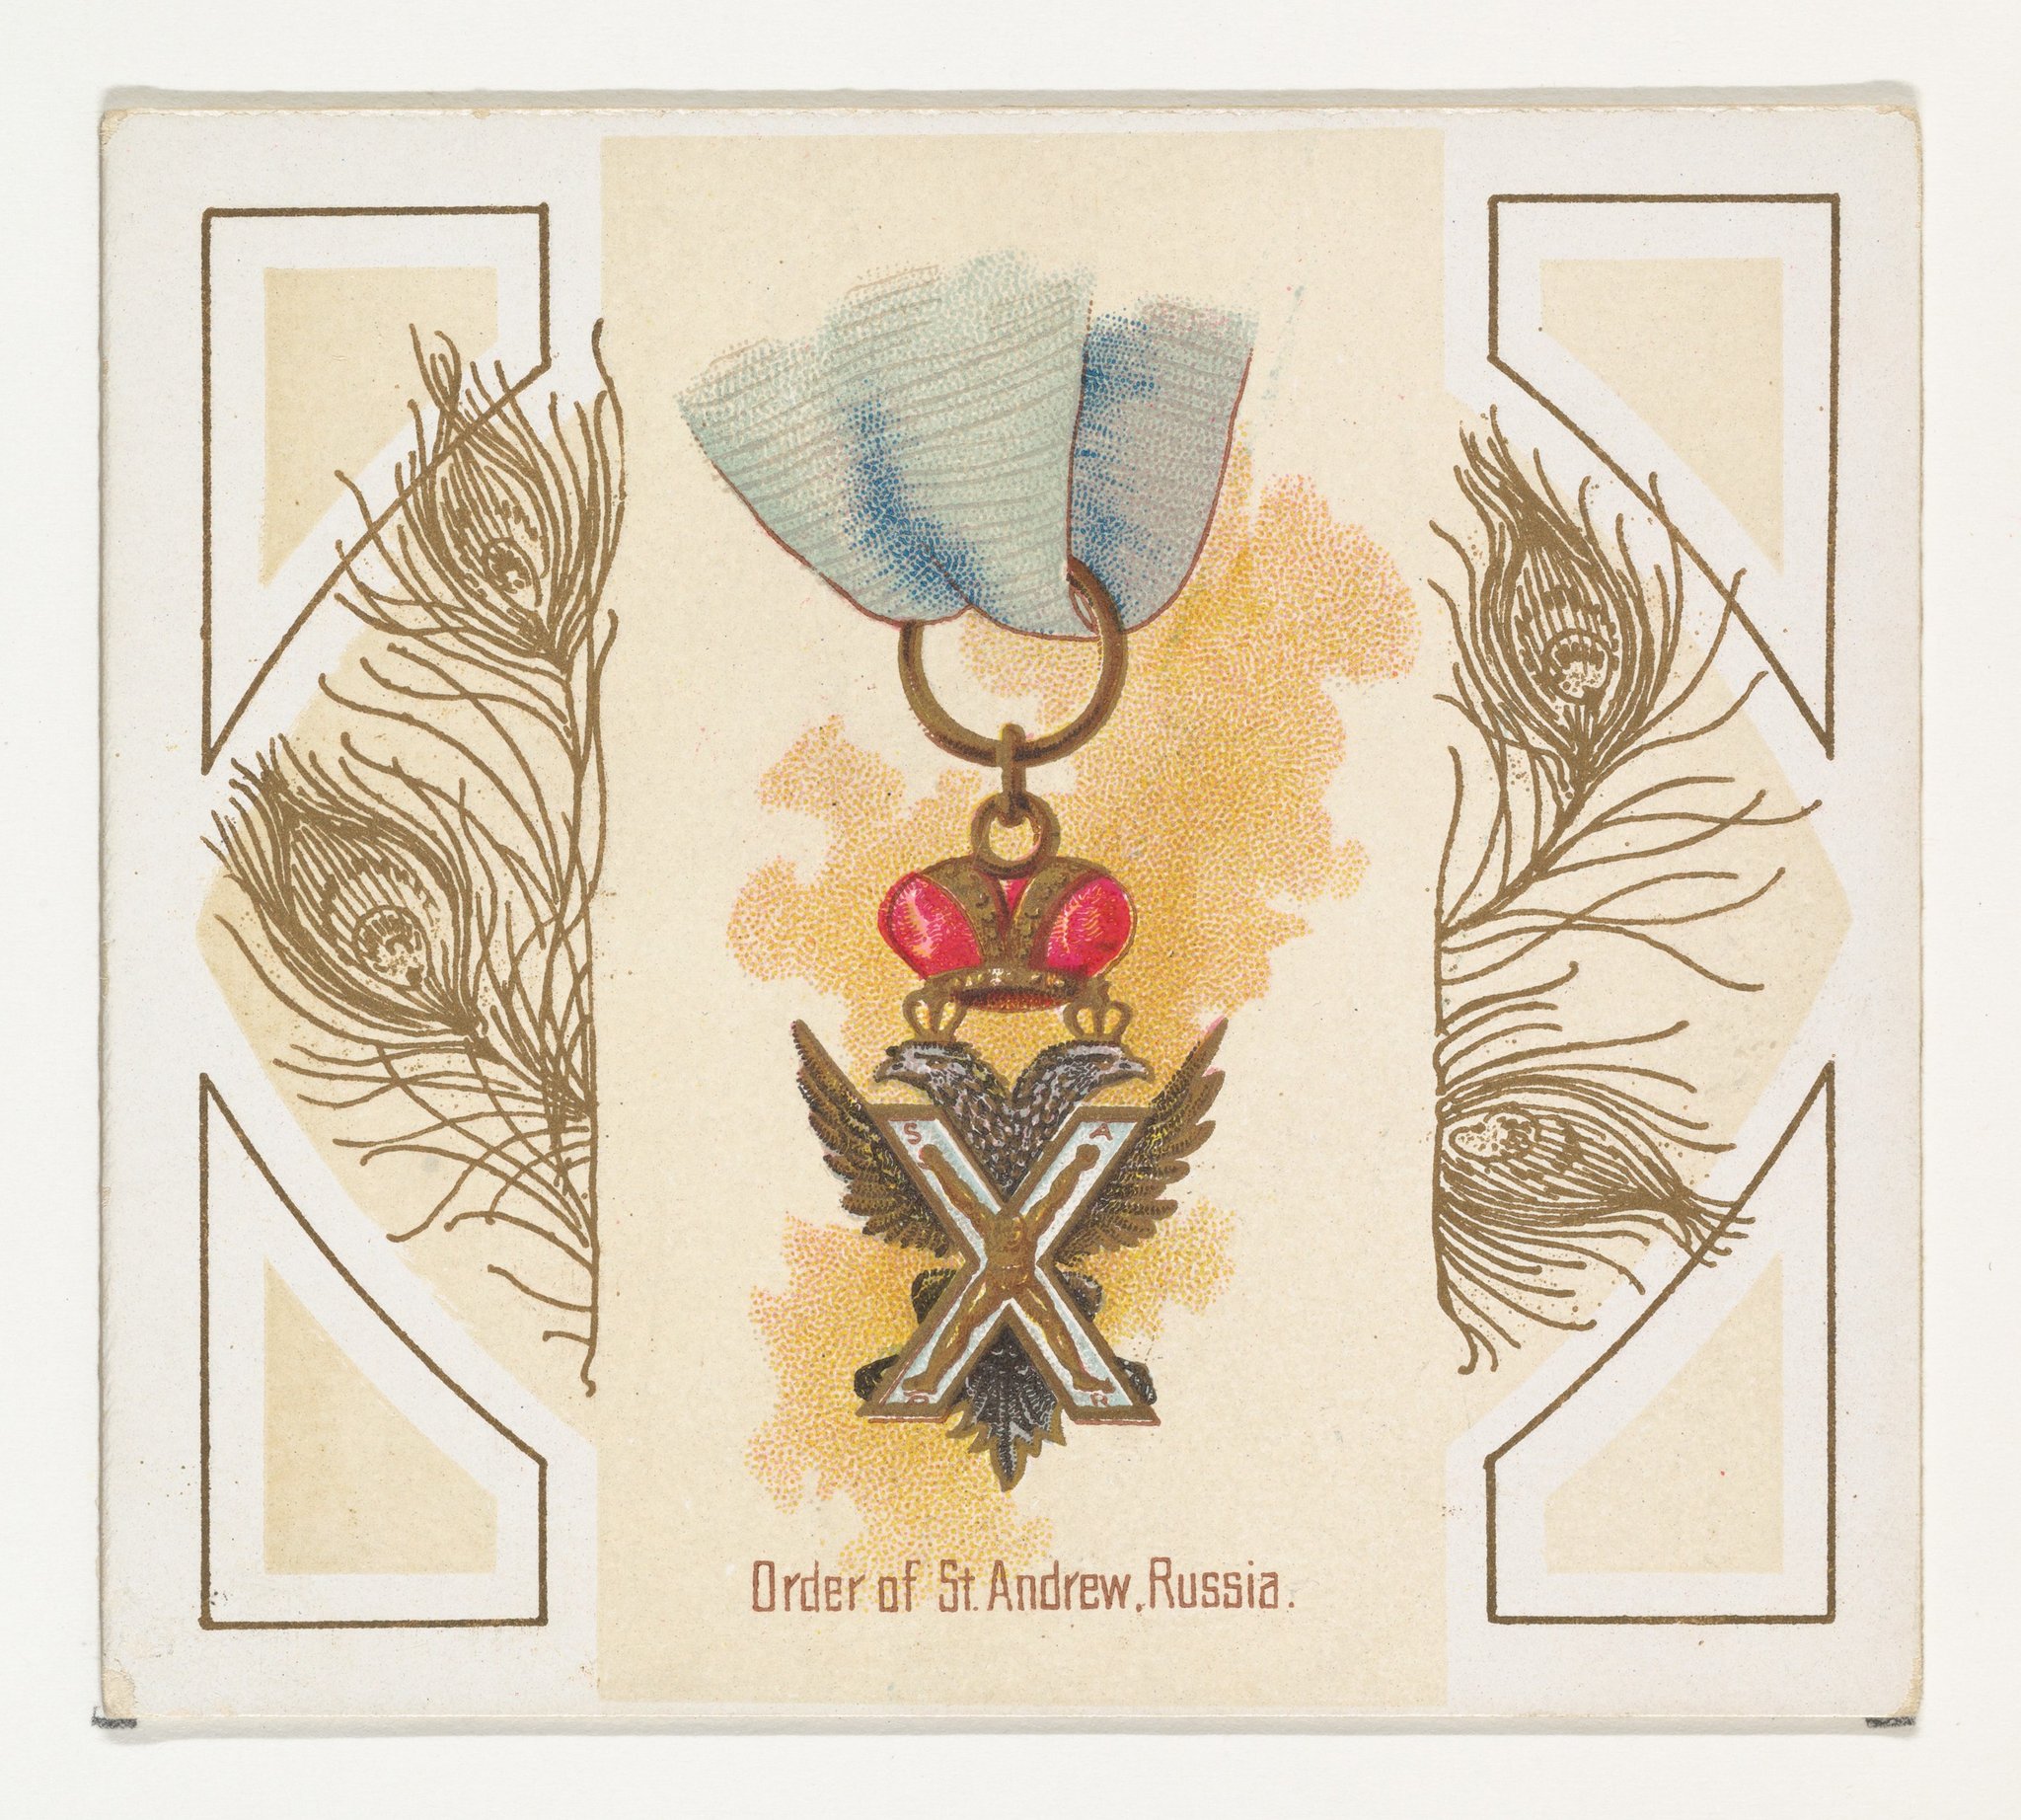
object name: print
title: Order of Saint Andrew, Russia, from the World's Decorations series (N44) for Allen & Ginter Cigarettes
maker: allen & ginter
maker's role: publisher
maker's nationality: american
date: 1890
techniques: color lithograph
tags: medals